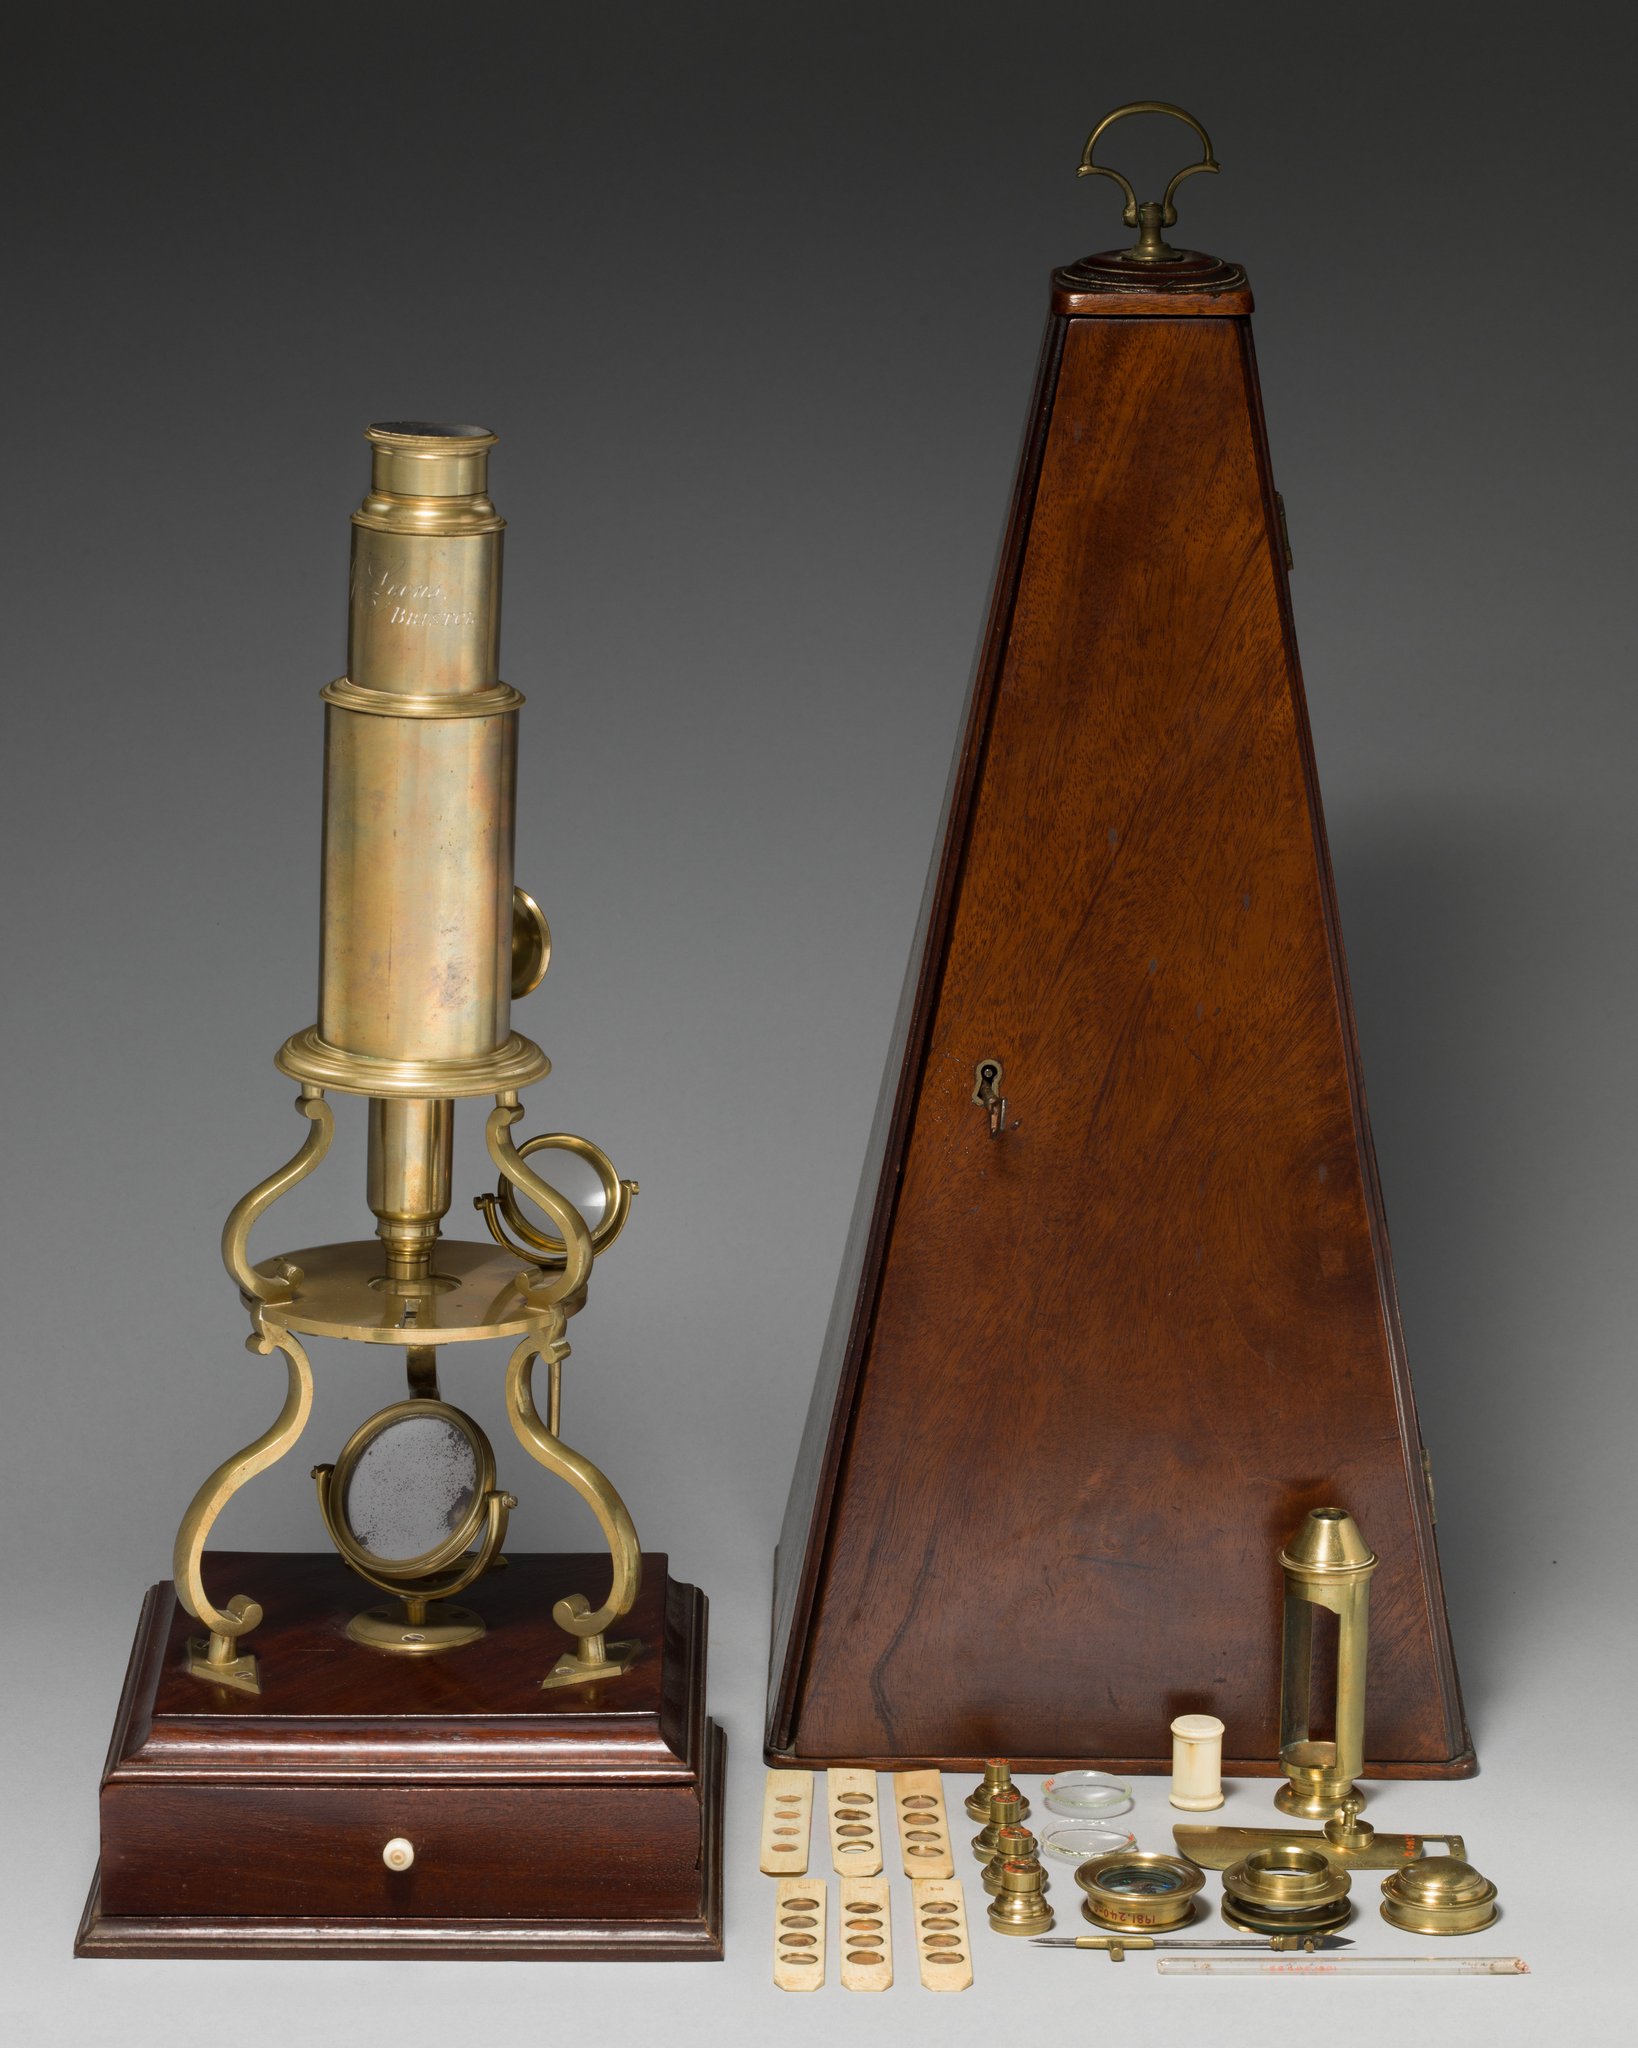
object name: microscope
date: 1801-1833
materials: brass, wood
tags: science